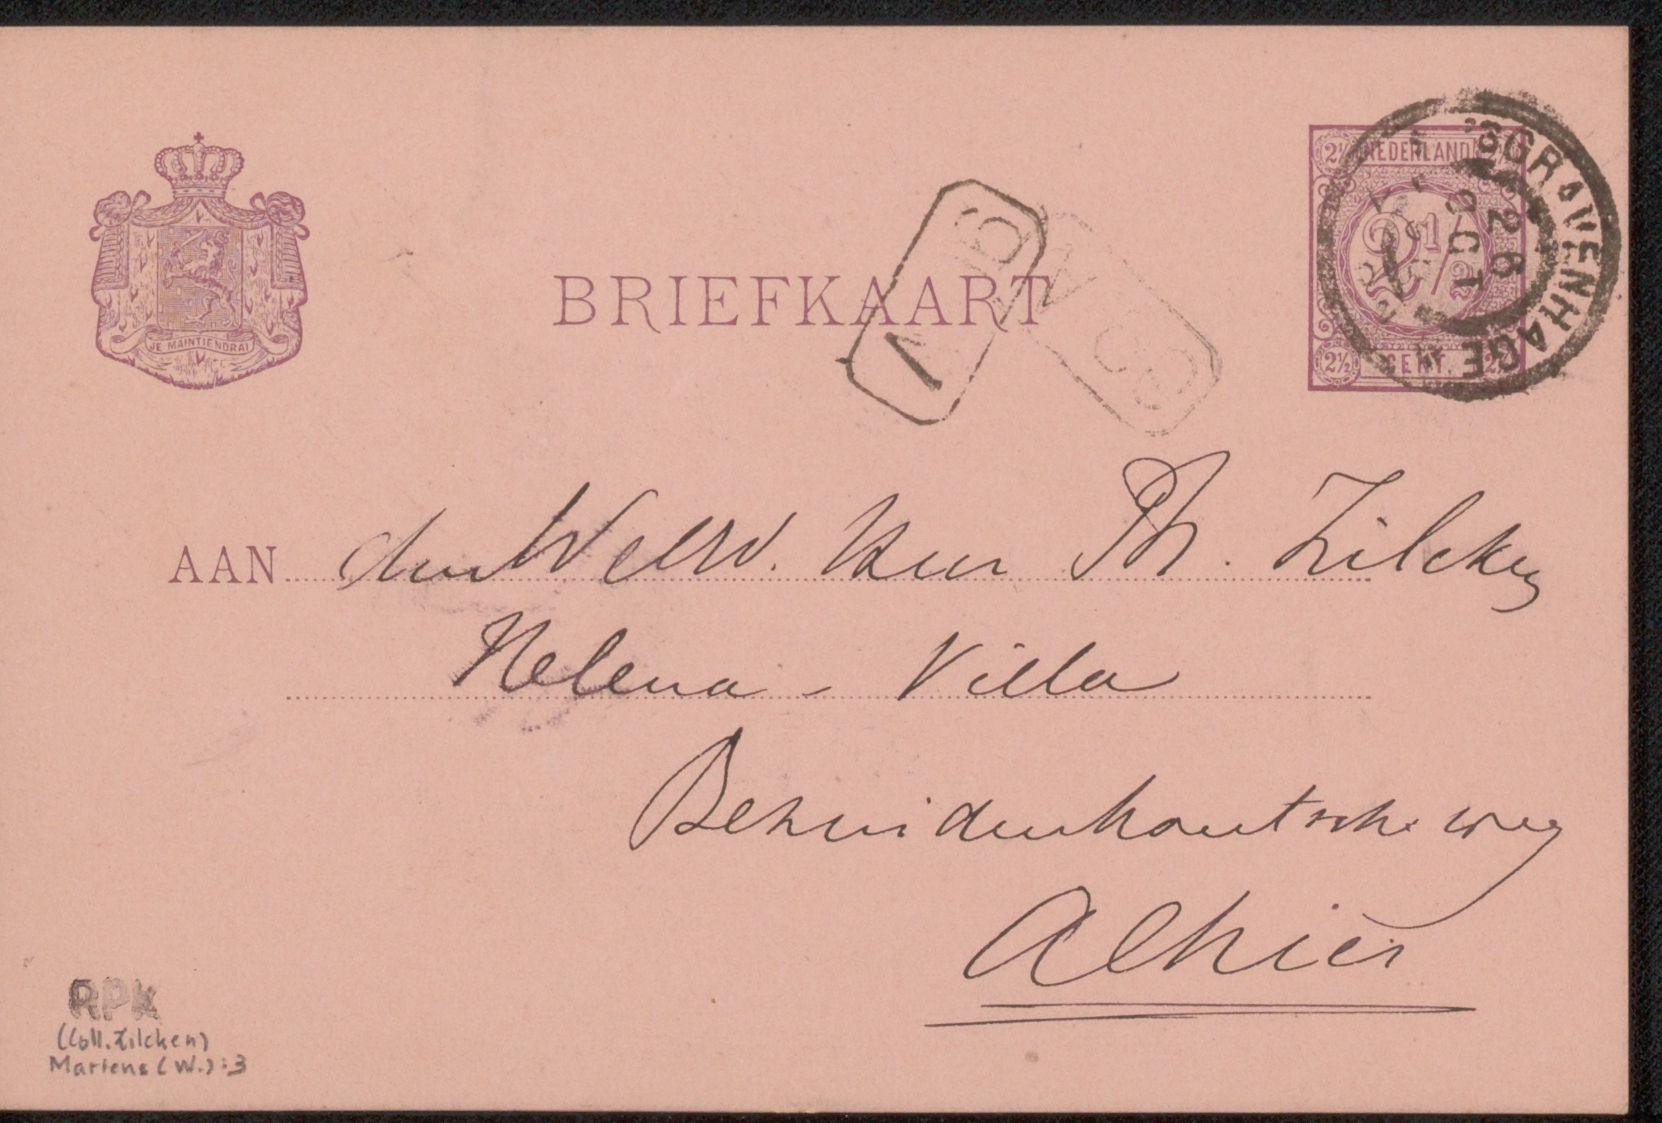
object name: postcard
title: Briefkaart aan Philip Zilcken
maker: willy martens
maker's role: painter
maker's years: 1856-1927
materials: cardboard, ink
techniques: pen, writing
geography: the hague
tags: philip zilcken, drawing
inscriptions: collector's mark: ‘RPK’